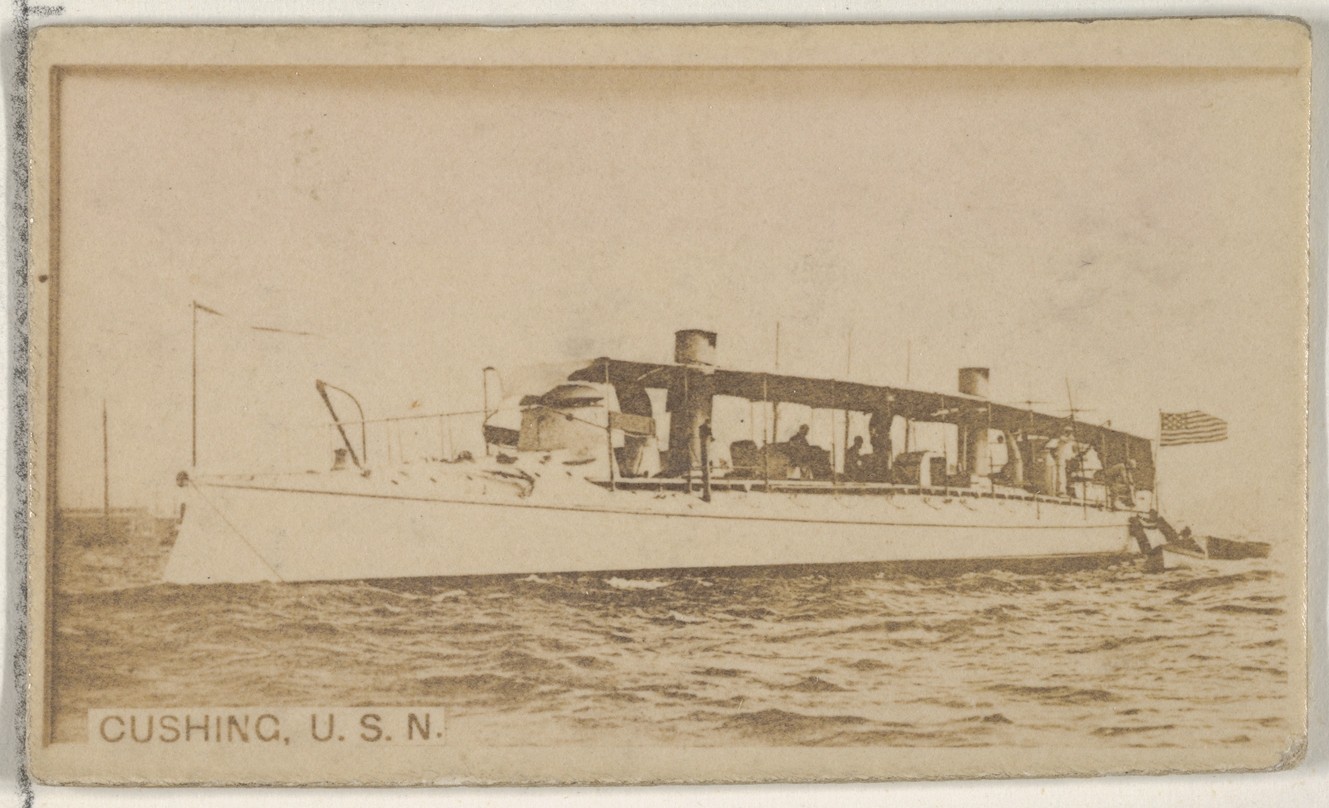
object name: photograph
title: Cushing, U.S.N., from the Famous Ships series (N50) for Virginia Brights Cigarettes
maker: allen & ginter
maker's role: publisher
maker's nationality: american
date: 1895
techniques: albumen silver print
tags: ships